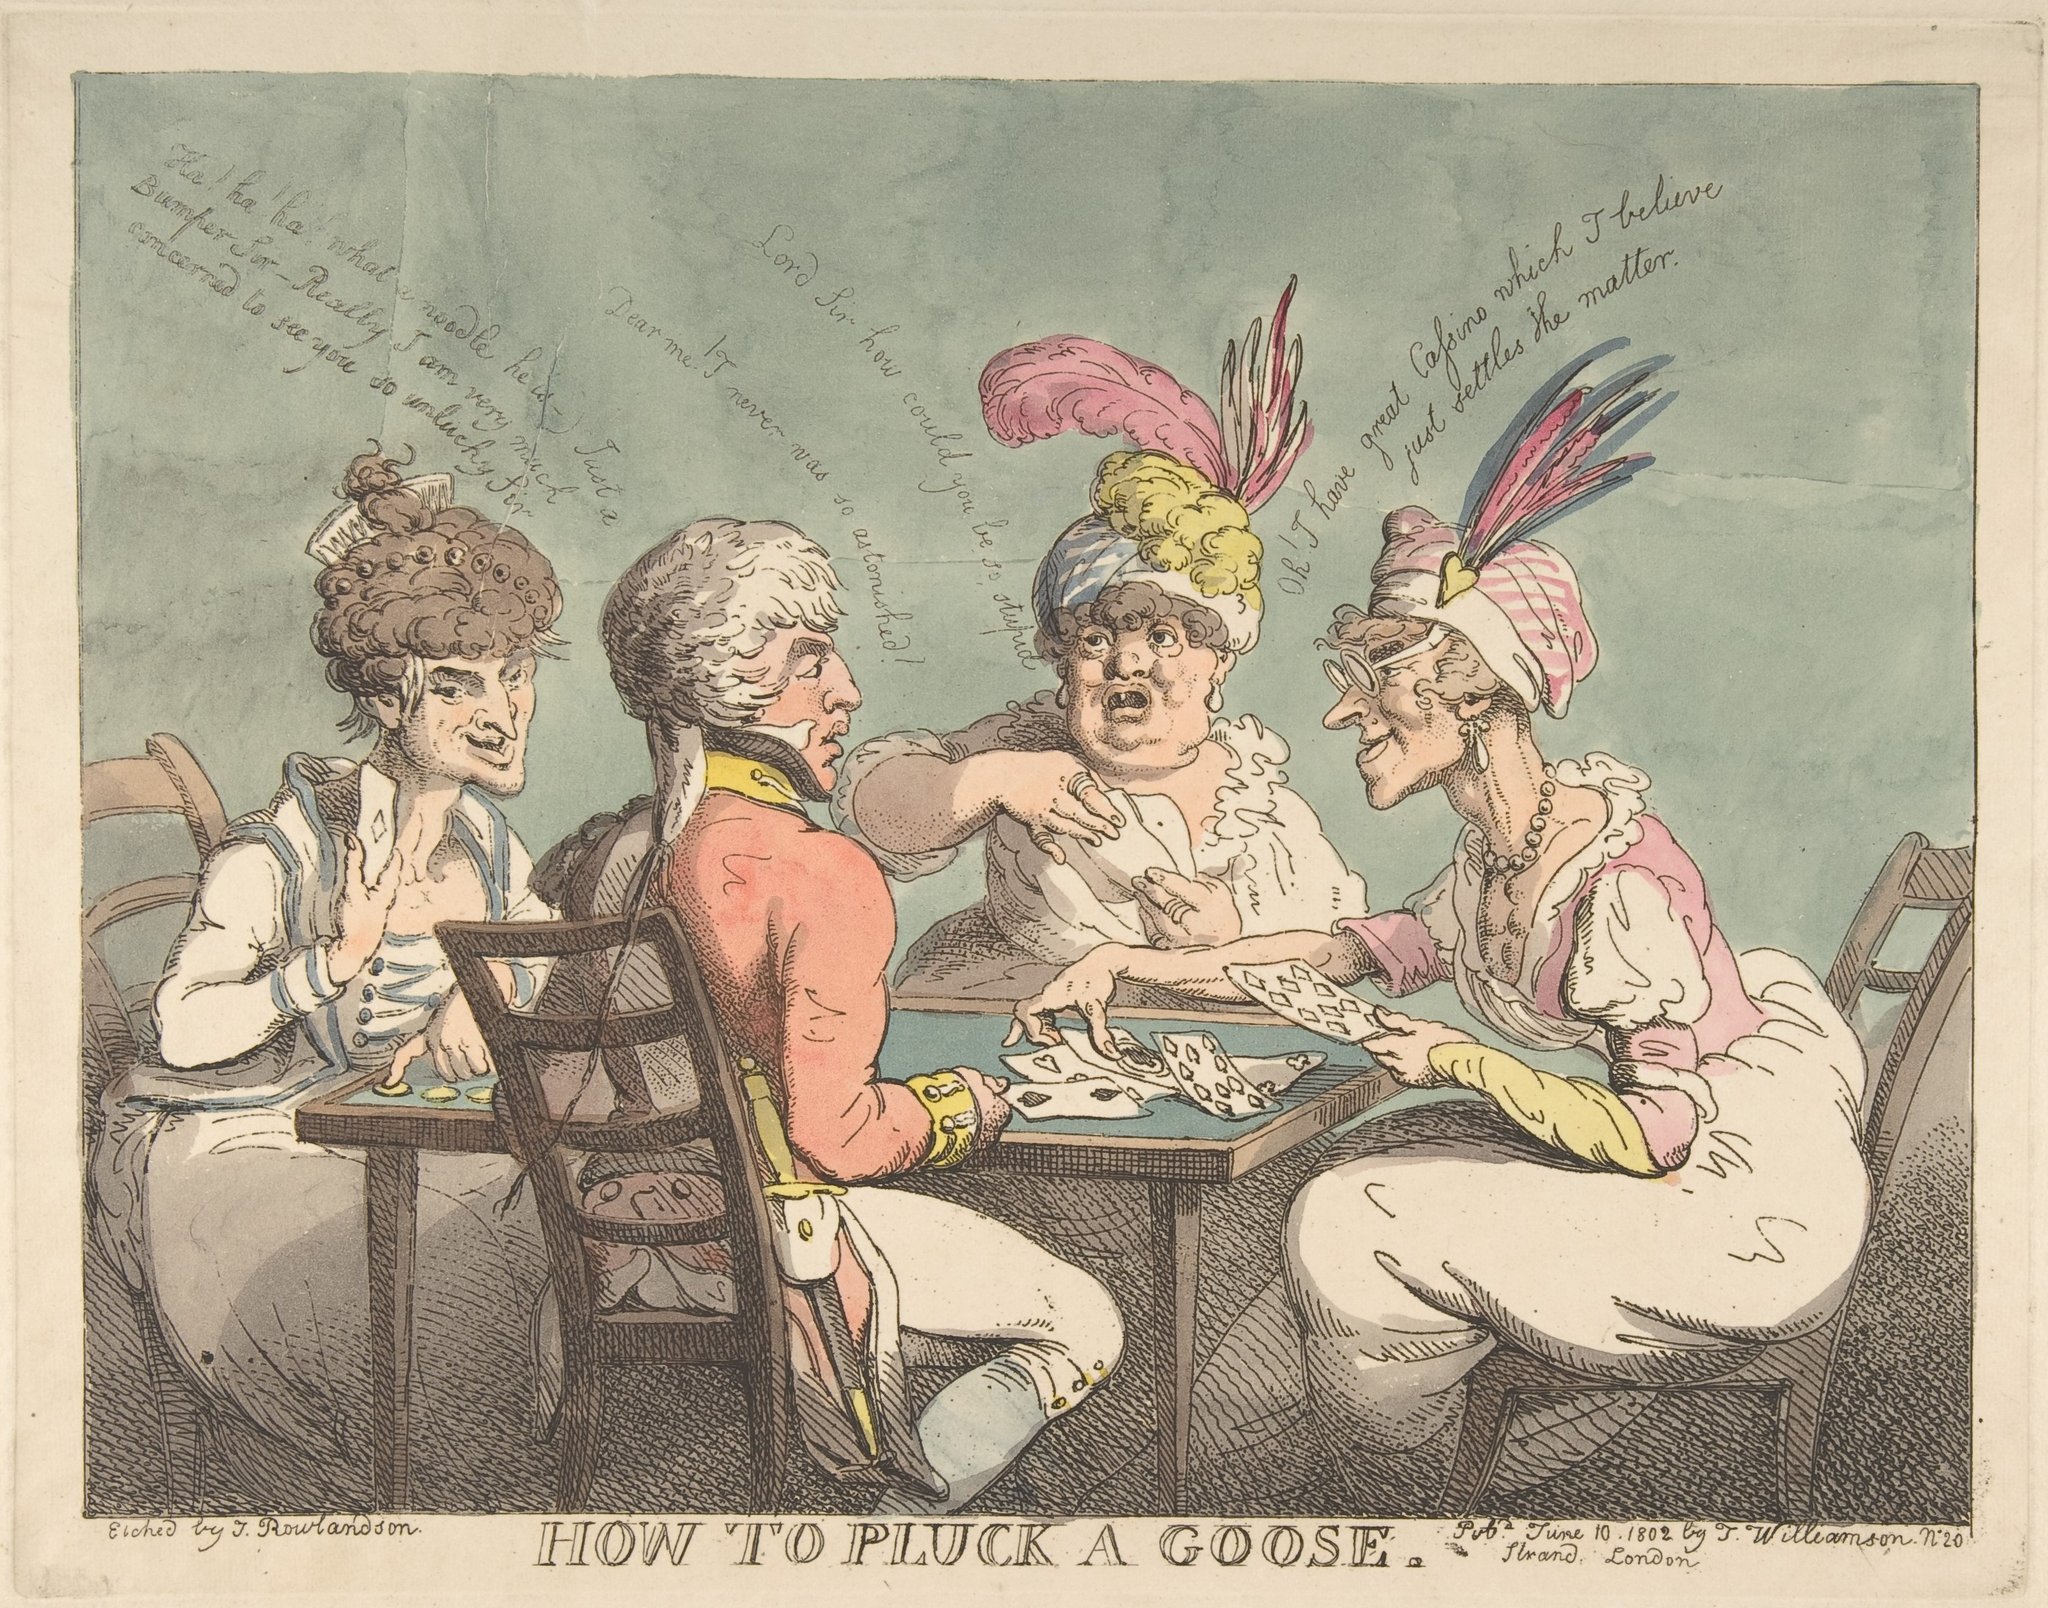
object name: print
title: How to Pluck a Goose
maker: thomas rowlandson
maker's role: artist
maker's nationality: british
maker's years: 1757-1827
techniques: etching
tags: men,women,playing cards